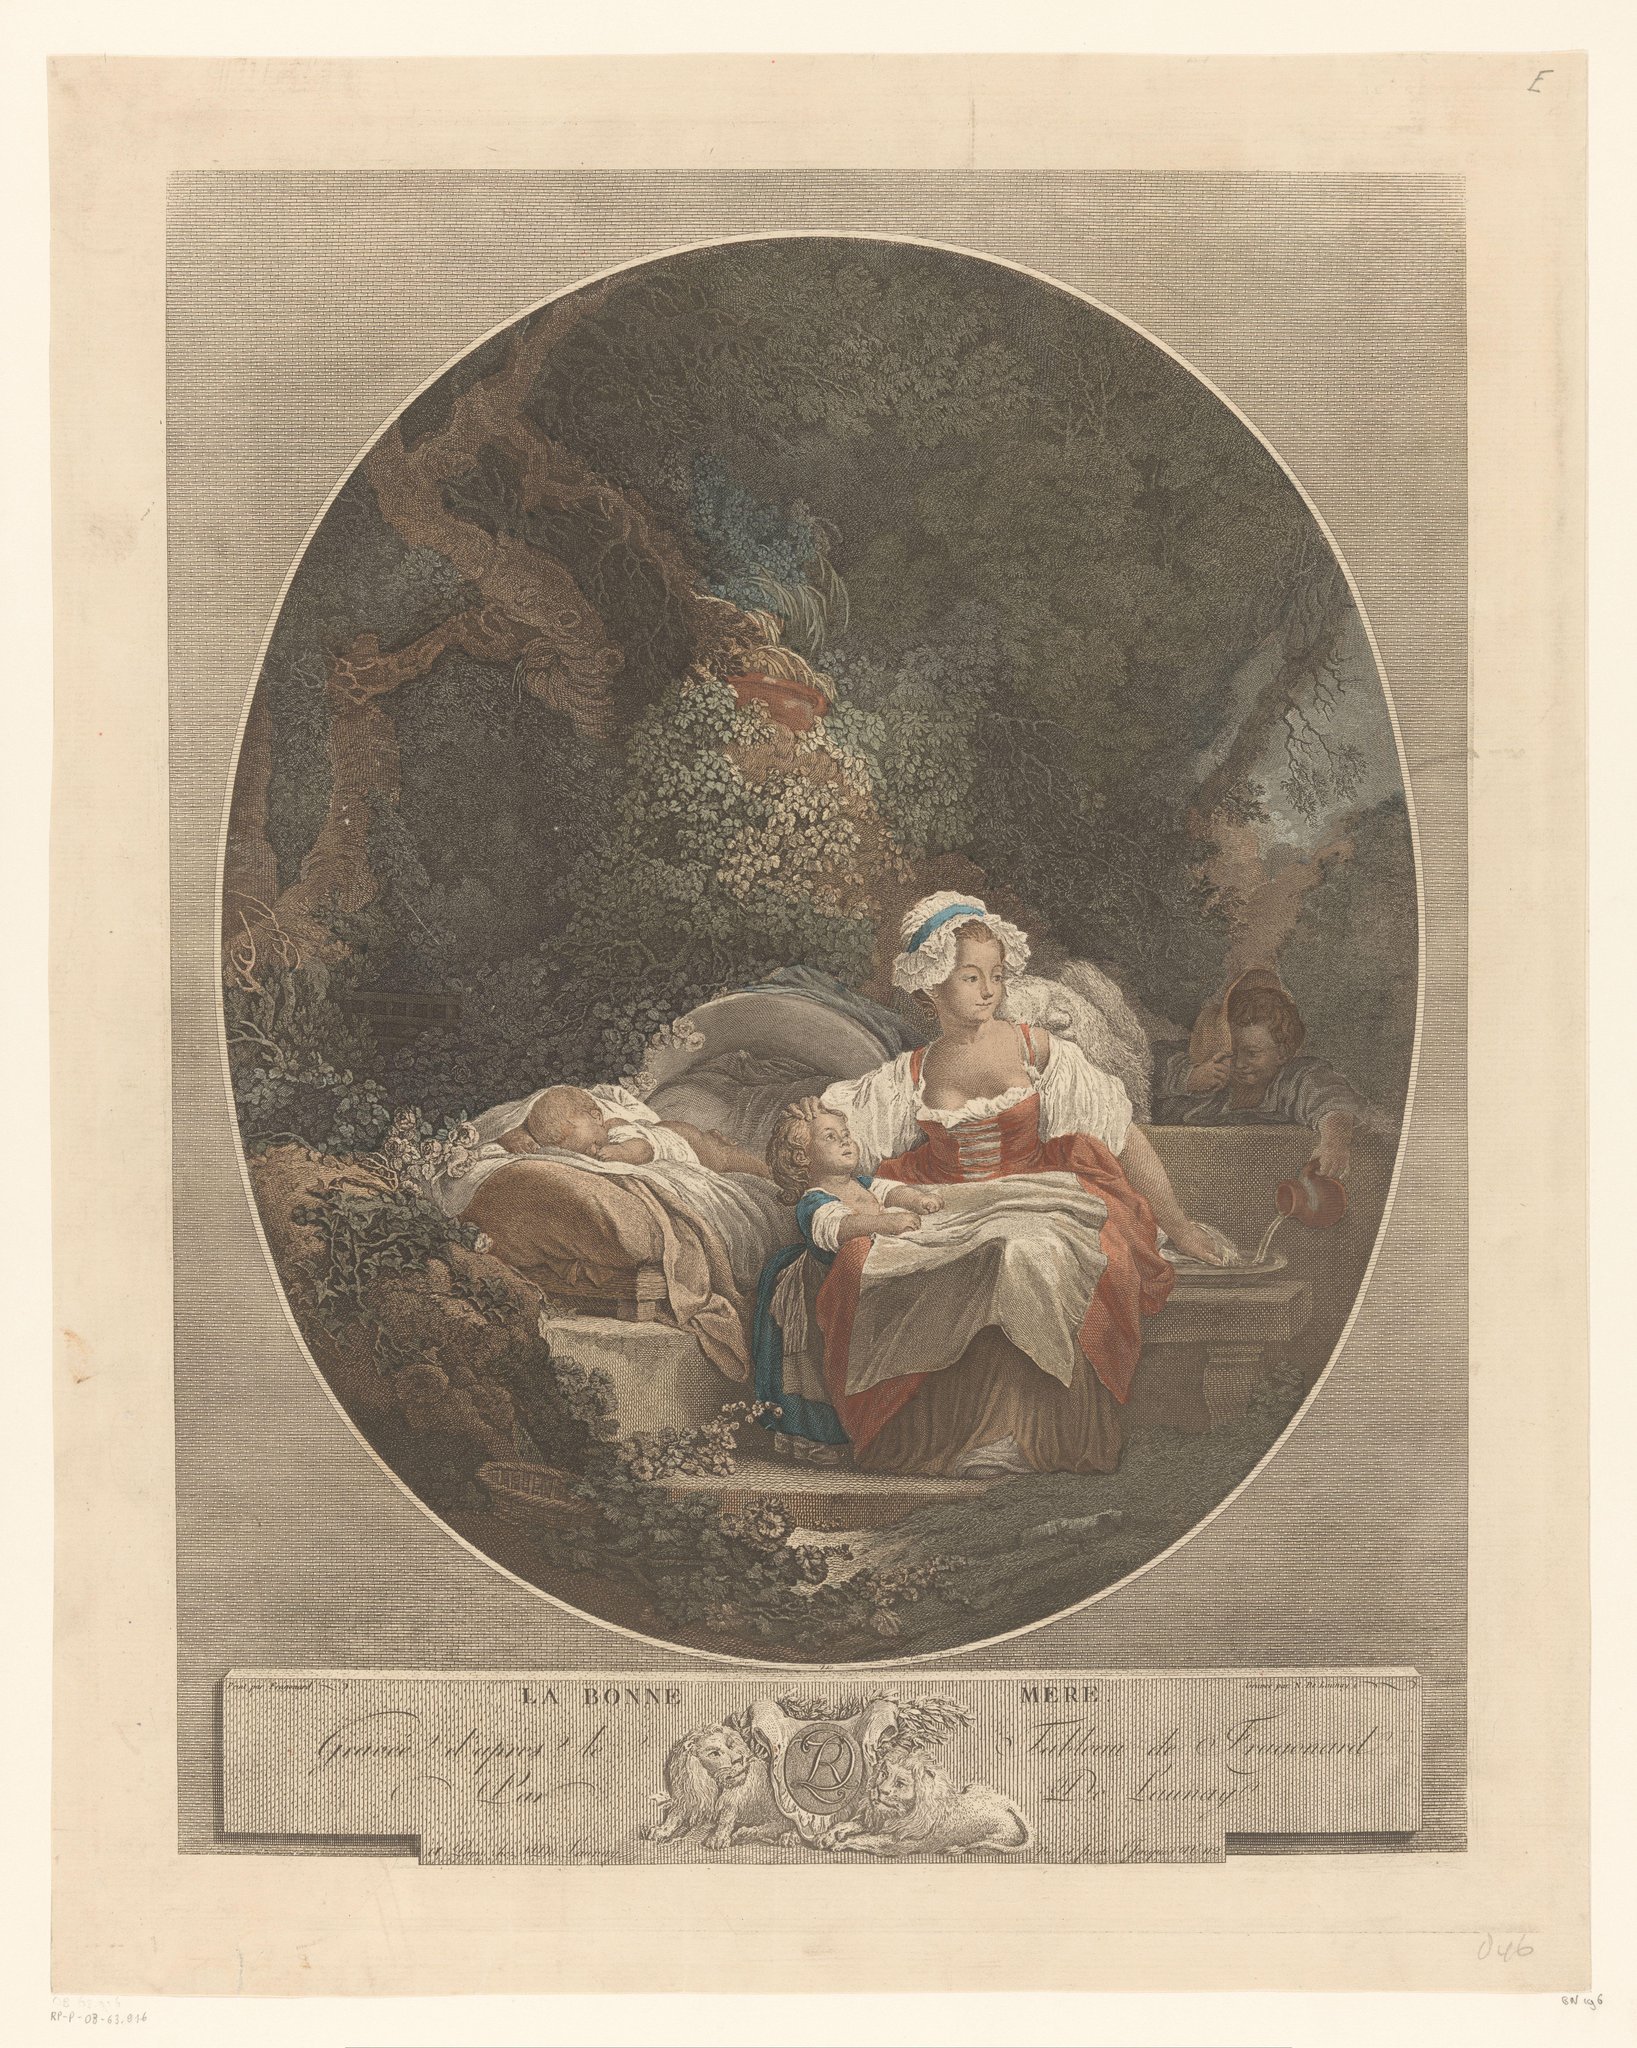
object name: print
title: Moeder met kinderen in een landschap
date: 1779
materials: paper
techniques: engraving, etching, hand coloring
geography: france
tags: landscapes, mother and baby or young child, armorial bearing, heraldry